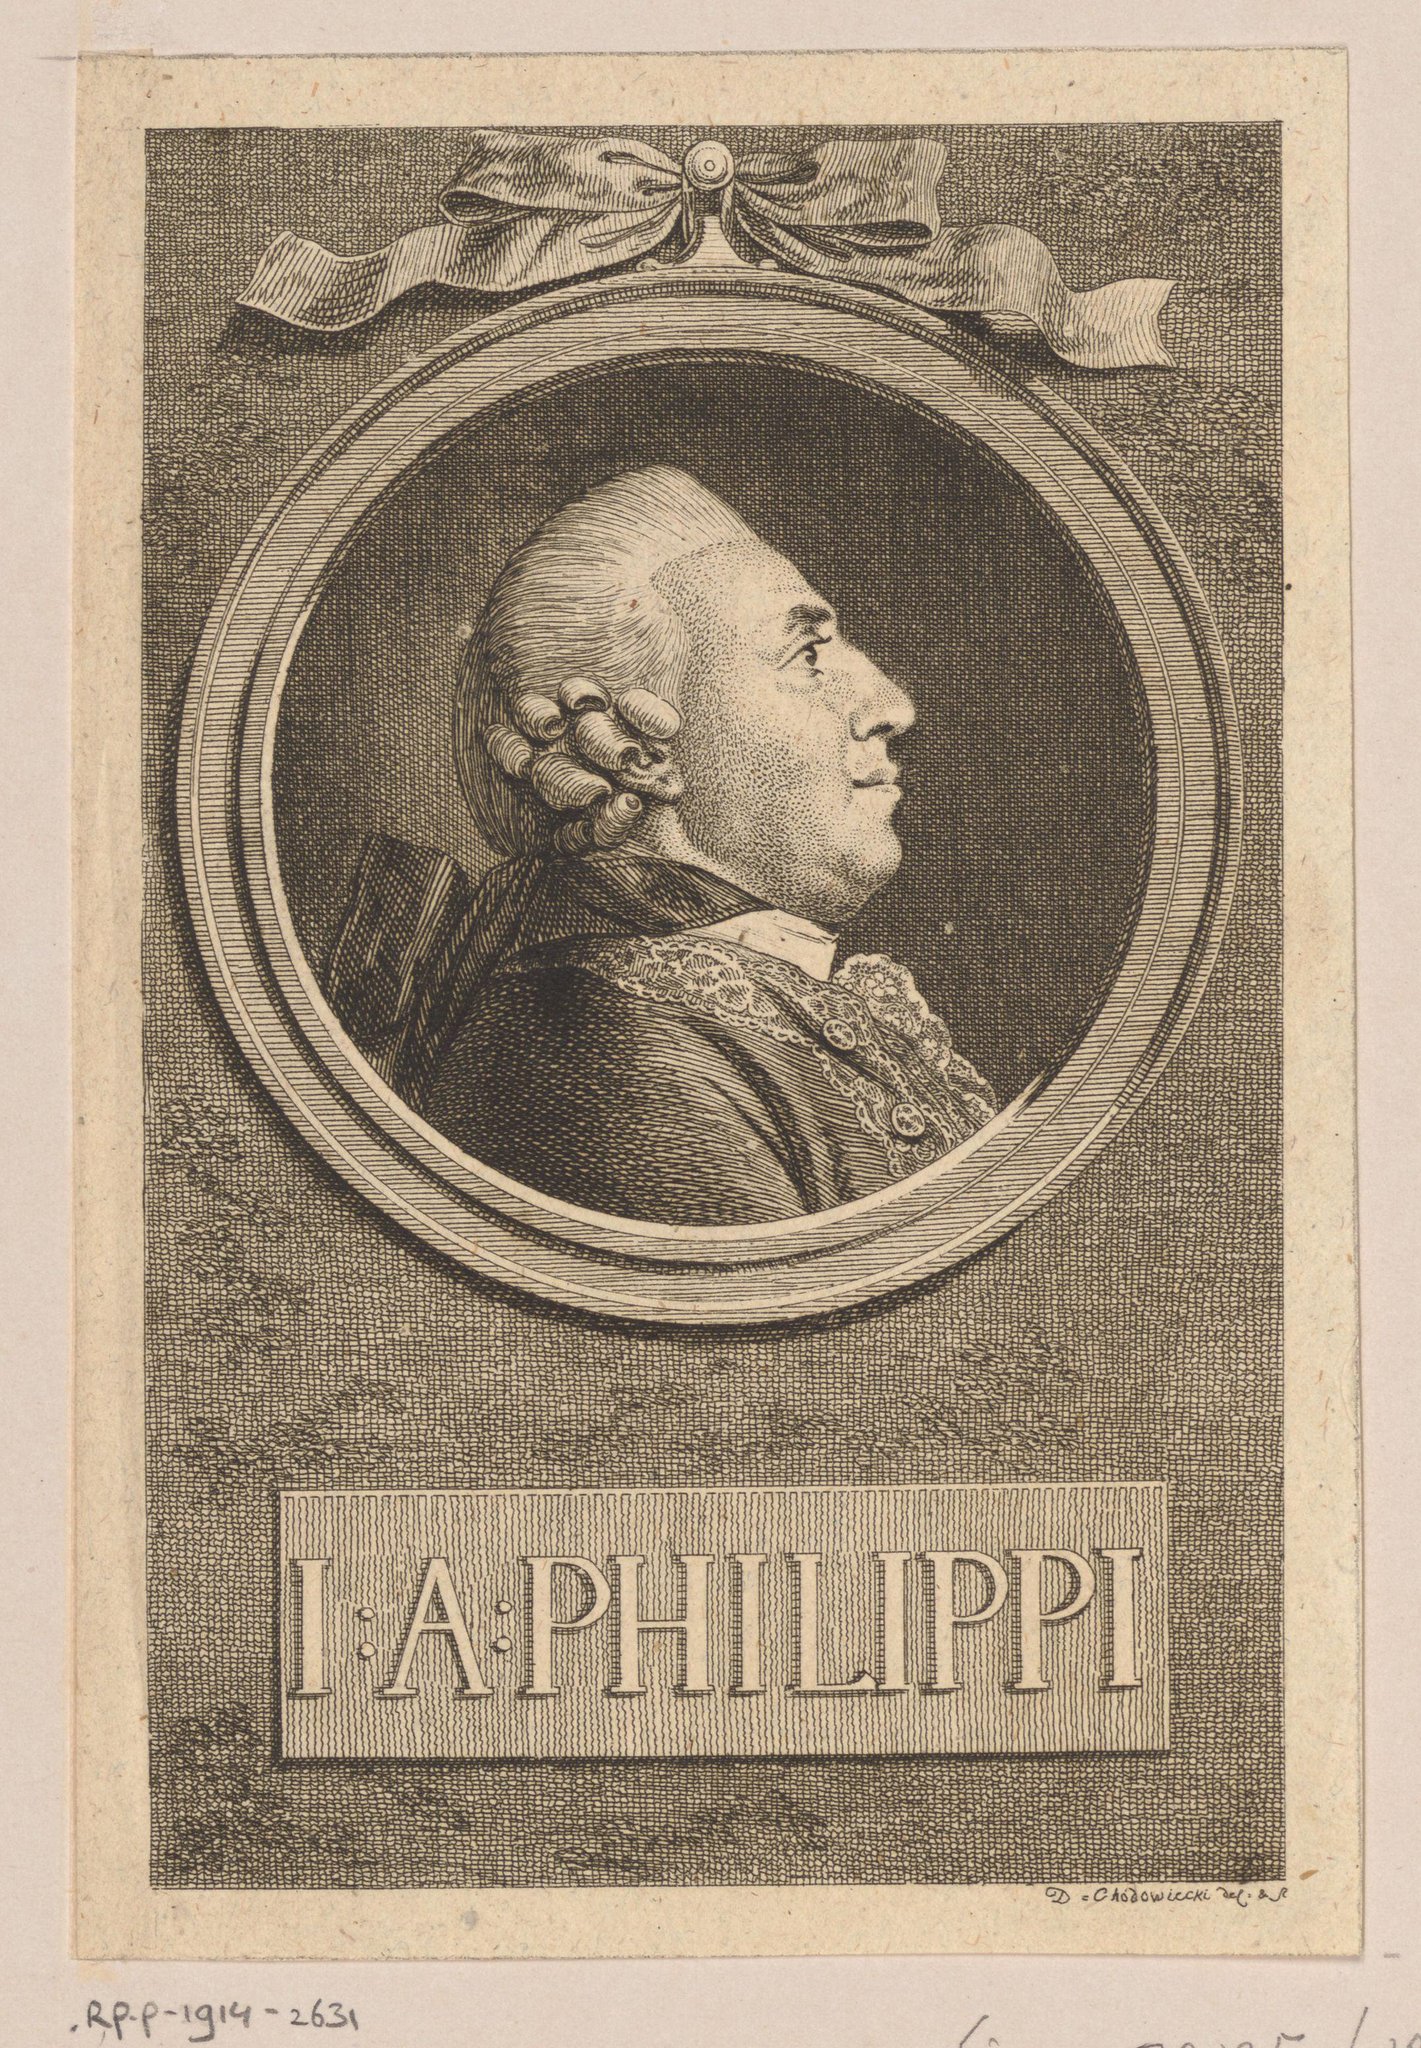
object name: print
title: Portret van Johann Albrecht Philippi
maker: daniel nikolaus chodowiecki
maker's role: draughtsman, print maker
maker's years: 1726-1801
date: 1773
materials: paper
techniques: etching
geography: berlin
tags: adult man, historical persons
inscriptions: collector's mark: Lugt 2228